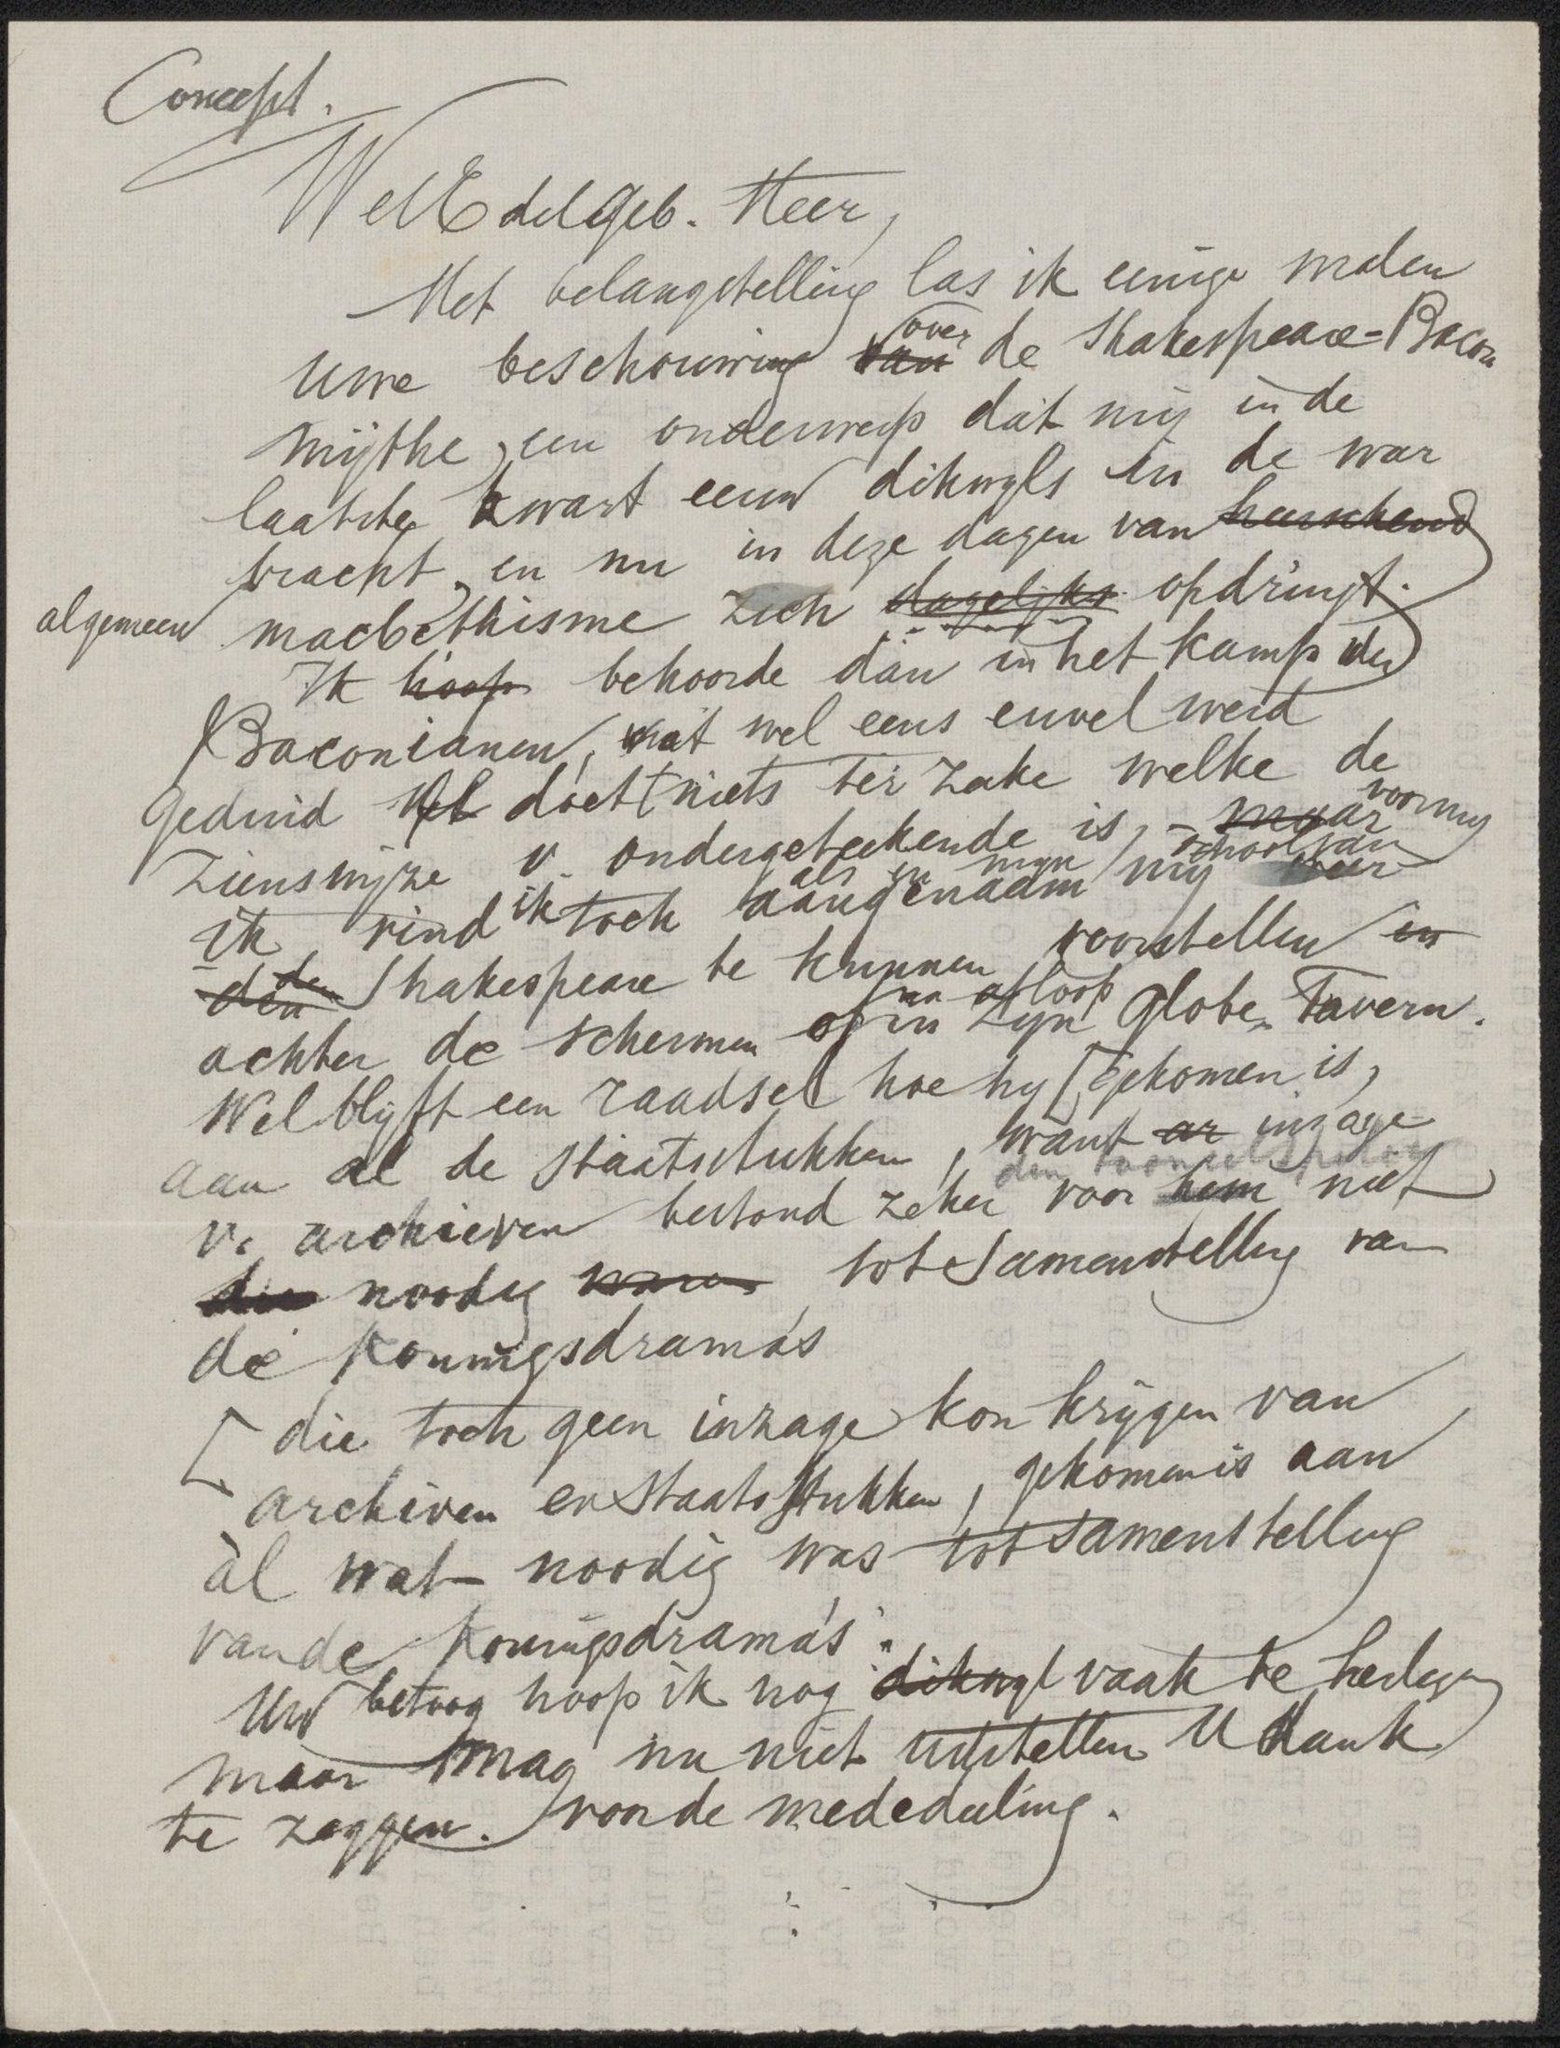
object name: letter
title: Conceptbrief aan anoniem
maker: august allebé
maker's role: draughtsman, print maker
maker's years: 1838-1927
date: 1848-1927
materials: ink, paper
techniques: pen, writing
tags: william shakespeare, london